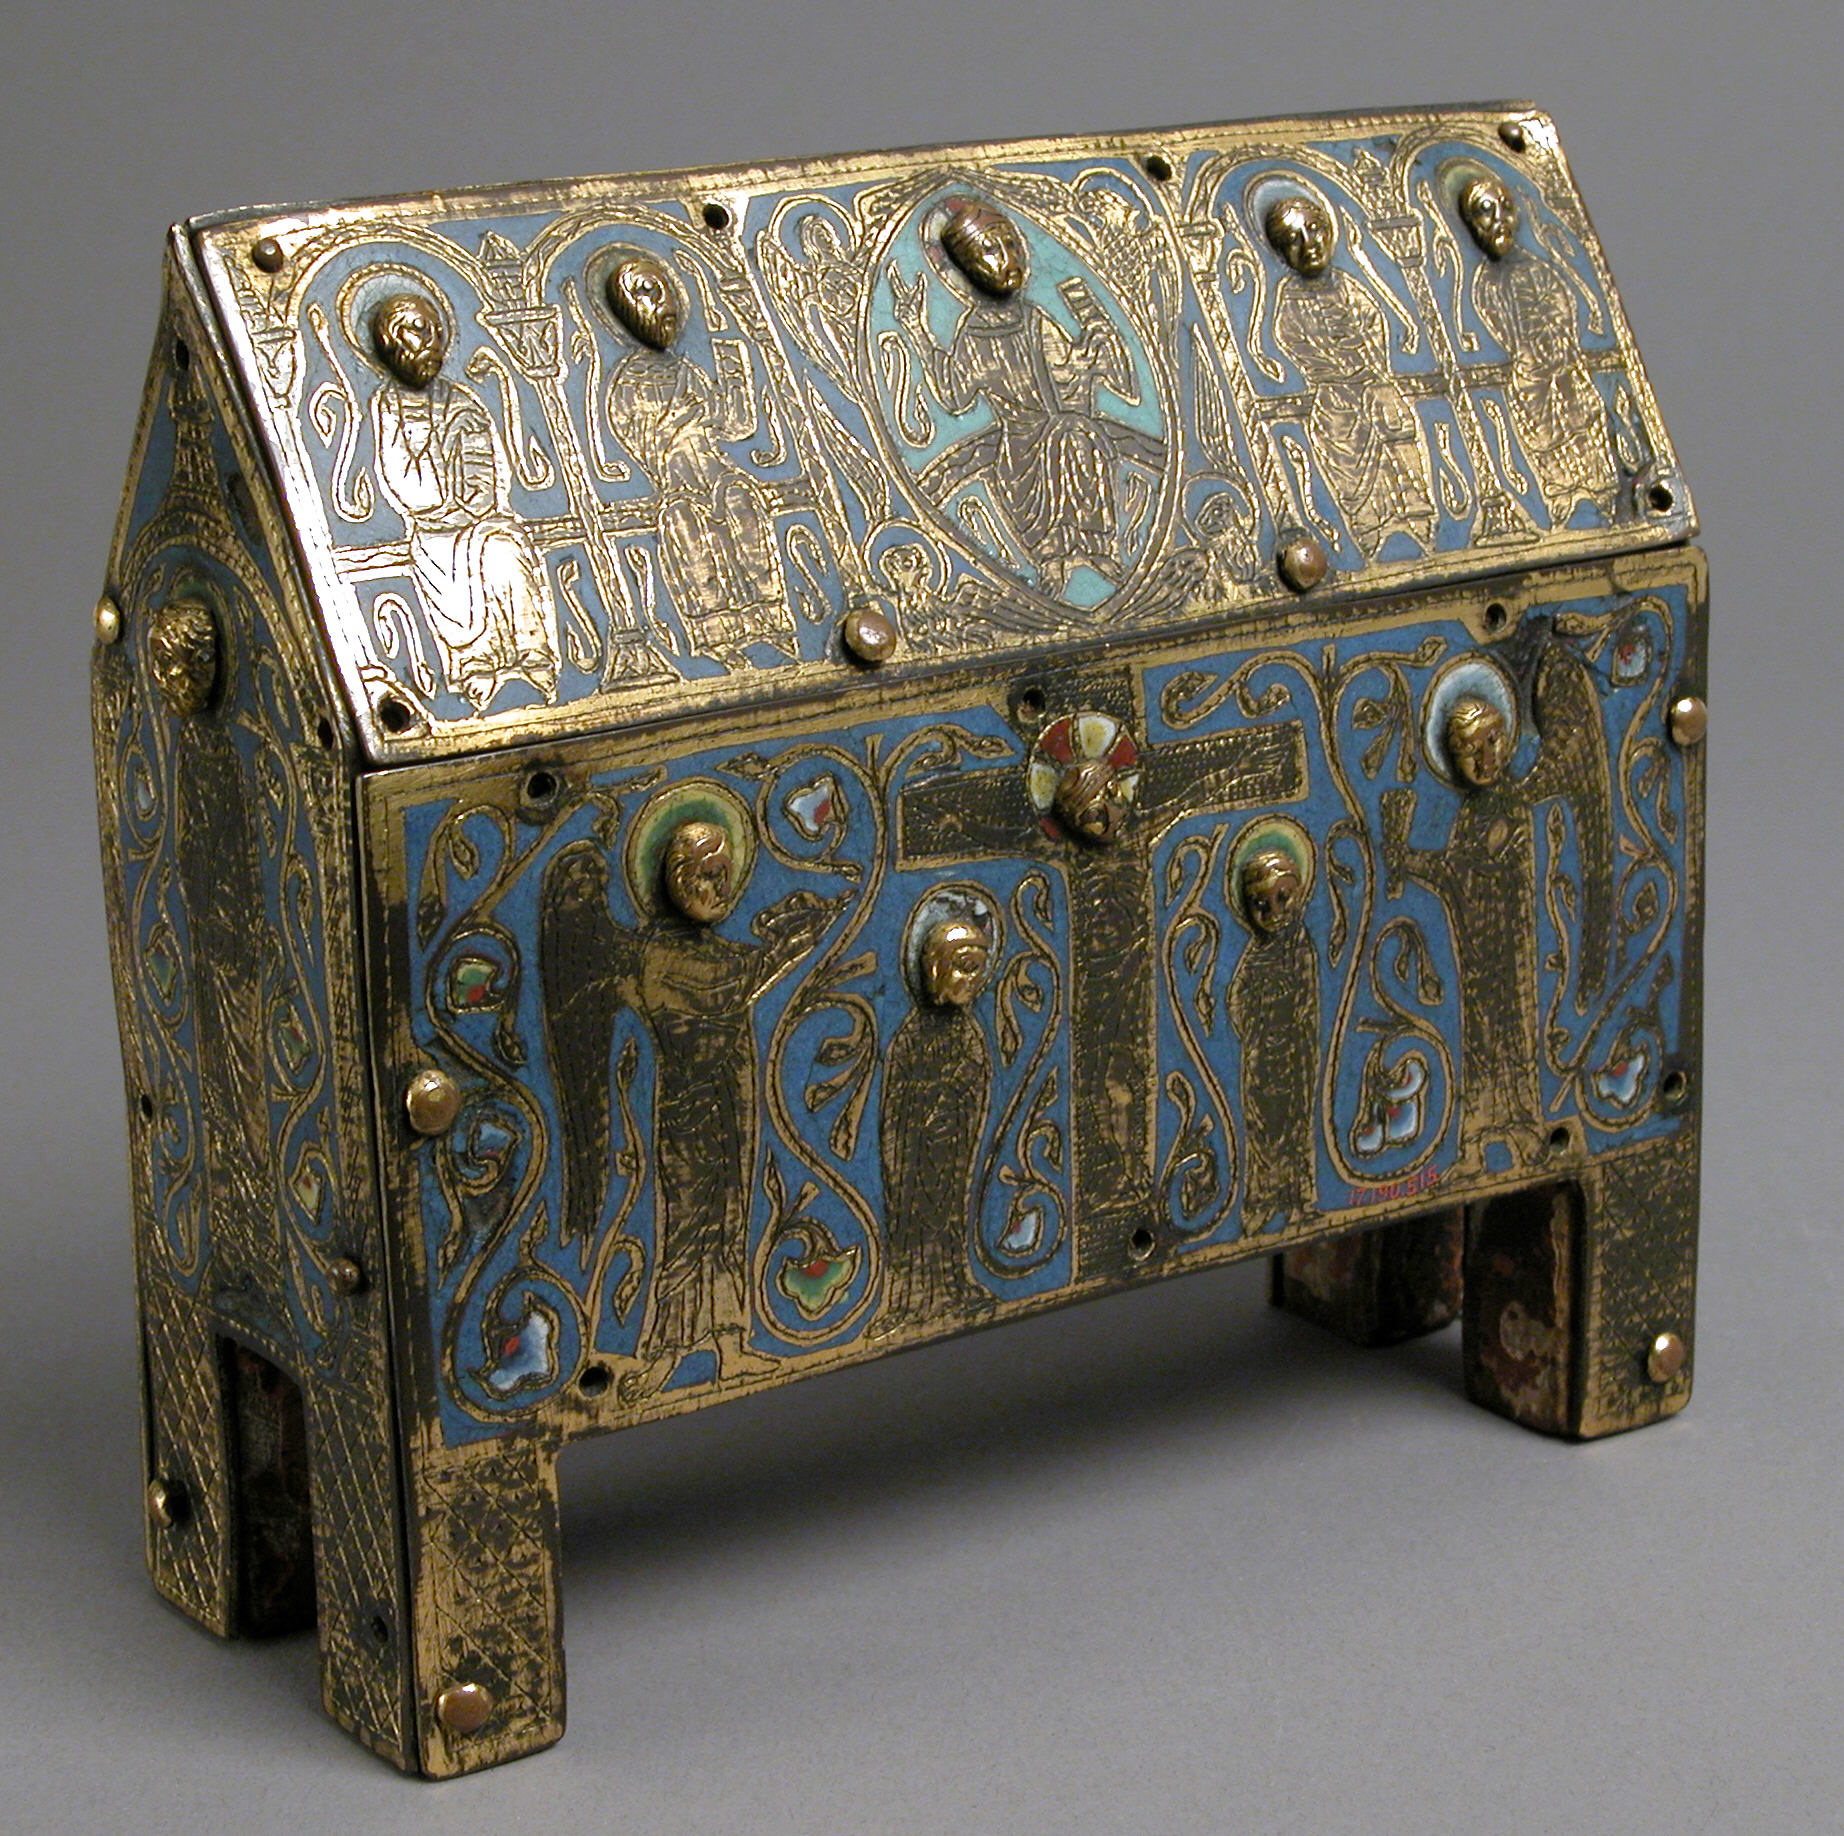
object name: chasse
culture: french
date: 1201-1300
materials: gilt copper, enamel, wood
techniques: enamel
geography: france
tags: angels,apostles,christ,virgin mary,crucifixion